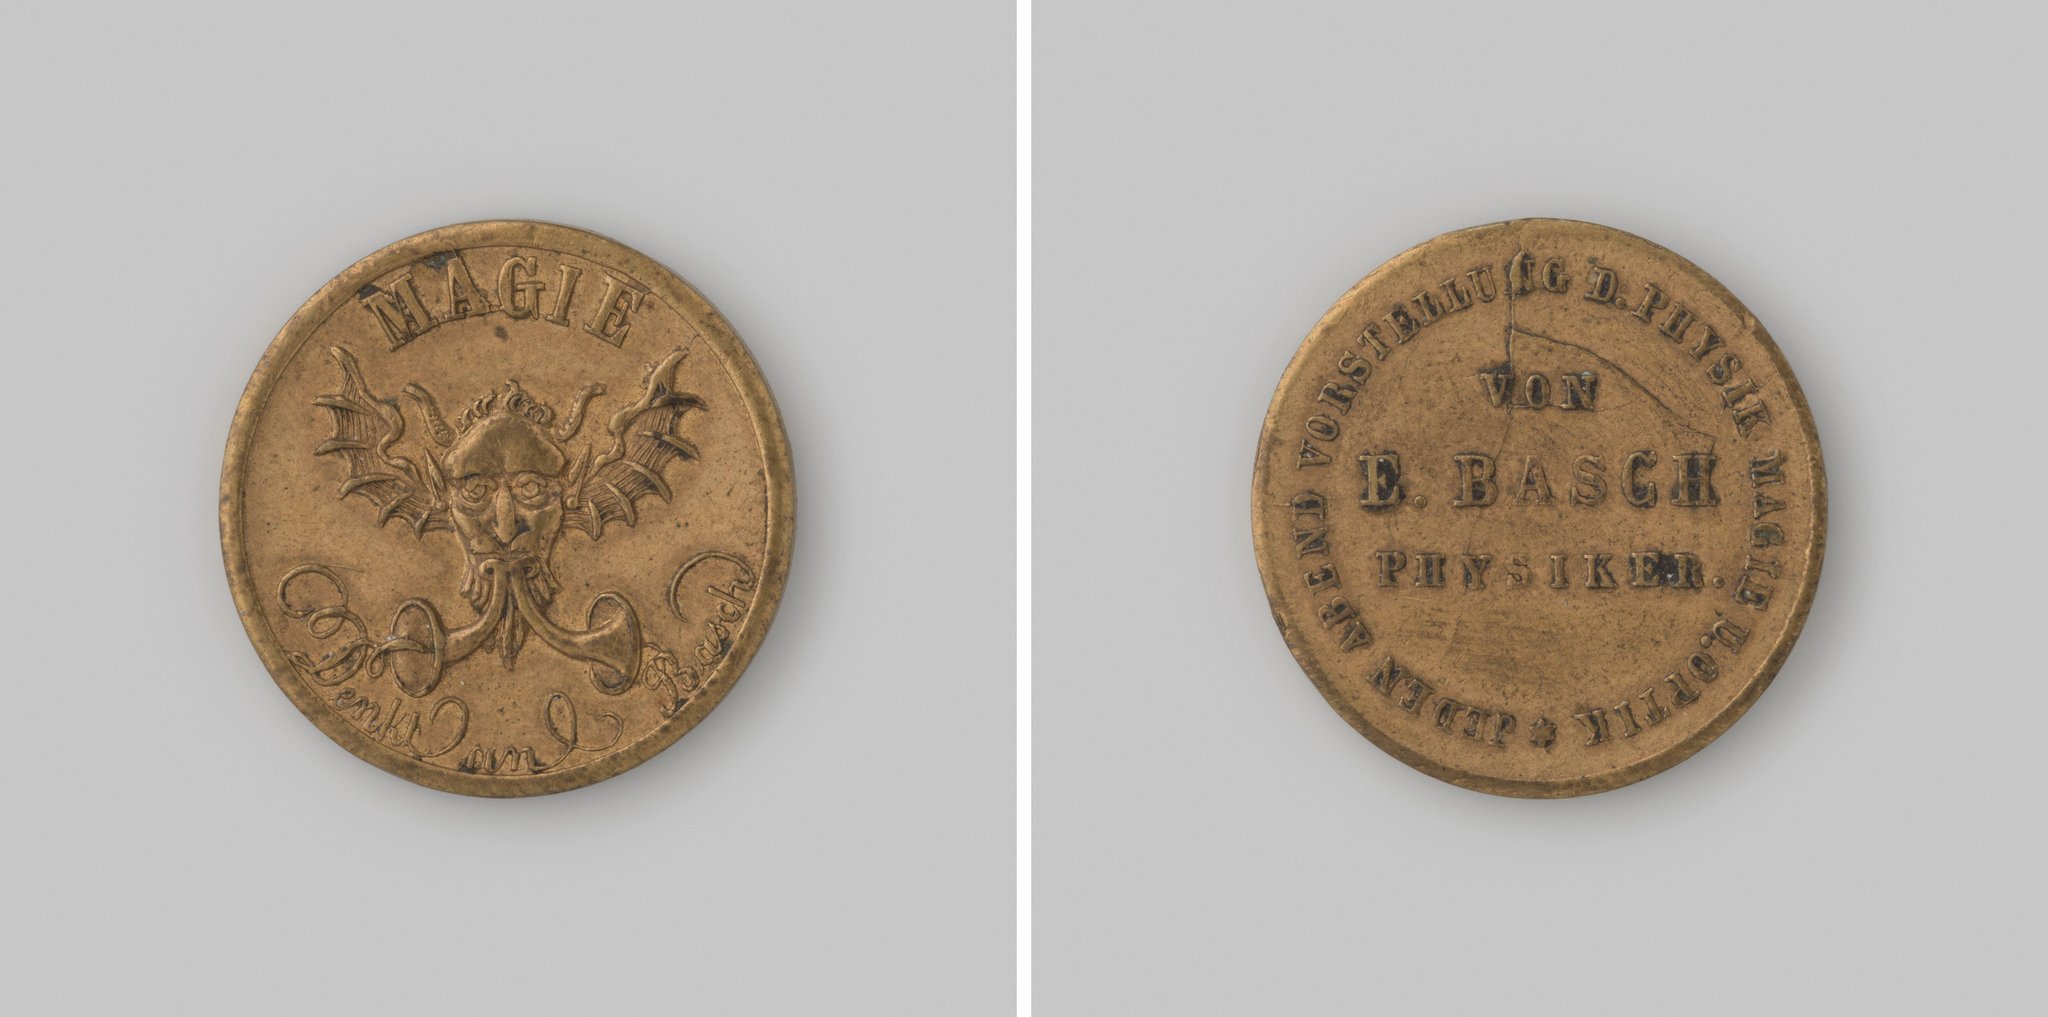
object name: history medal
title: Duitse reclamepenning van magiër E. Basch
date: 1875-1914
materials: brass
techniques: striking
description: Messing penning, op de voorzijde een aanziende drakenrkop met boven en onder omschrift, op de keerzijde drie regels tekst met omschrift.